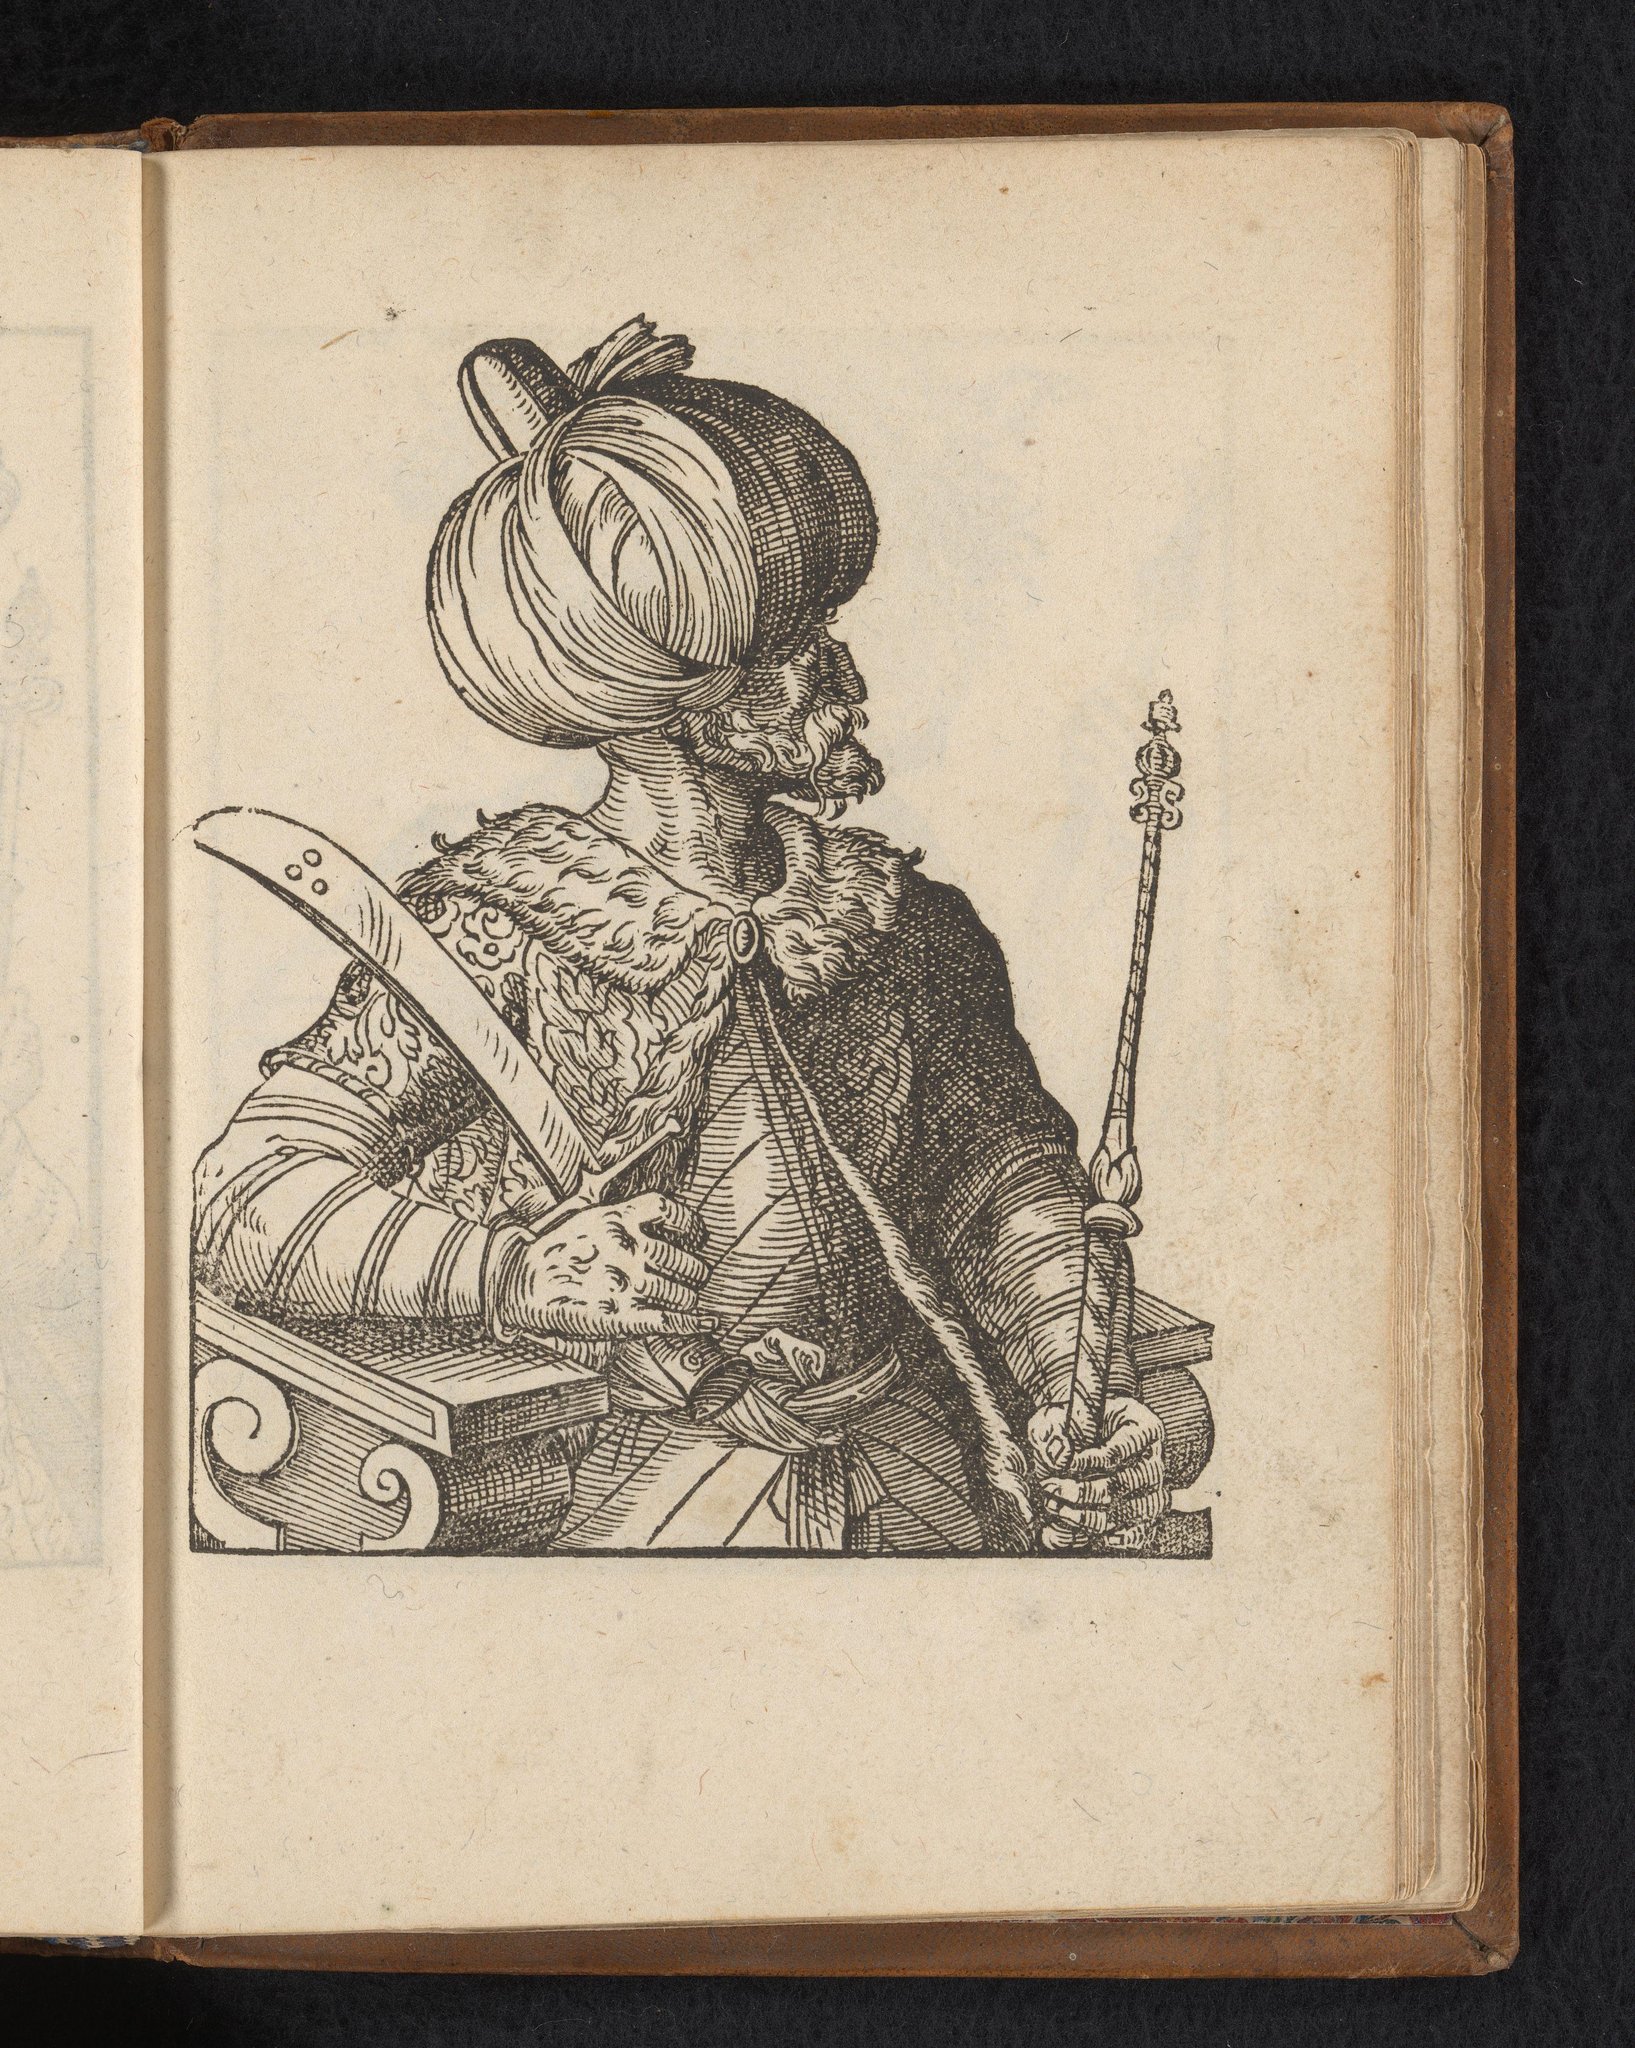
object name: print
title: Ottomaanse veldheer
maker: Anonymous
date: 1578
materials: paper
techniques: woodcut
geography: nuremberg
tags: asiatic races and peoples: turks, head-gear: turban, the soldier; the soldier's life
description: Een Ottomaanse veldheer, zittend met kromzwaard en scepter in de hand, op het hoofd een tulband. Onderdeel van het modelboek Enchiridion artis pingendi, fingendi & sculpendi met 108 figuren bedoeld voor beginnende schilders, beeldhouwers en prentmakers.